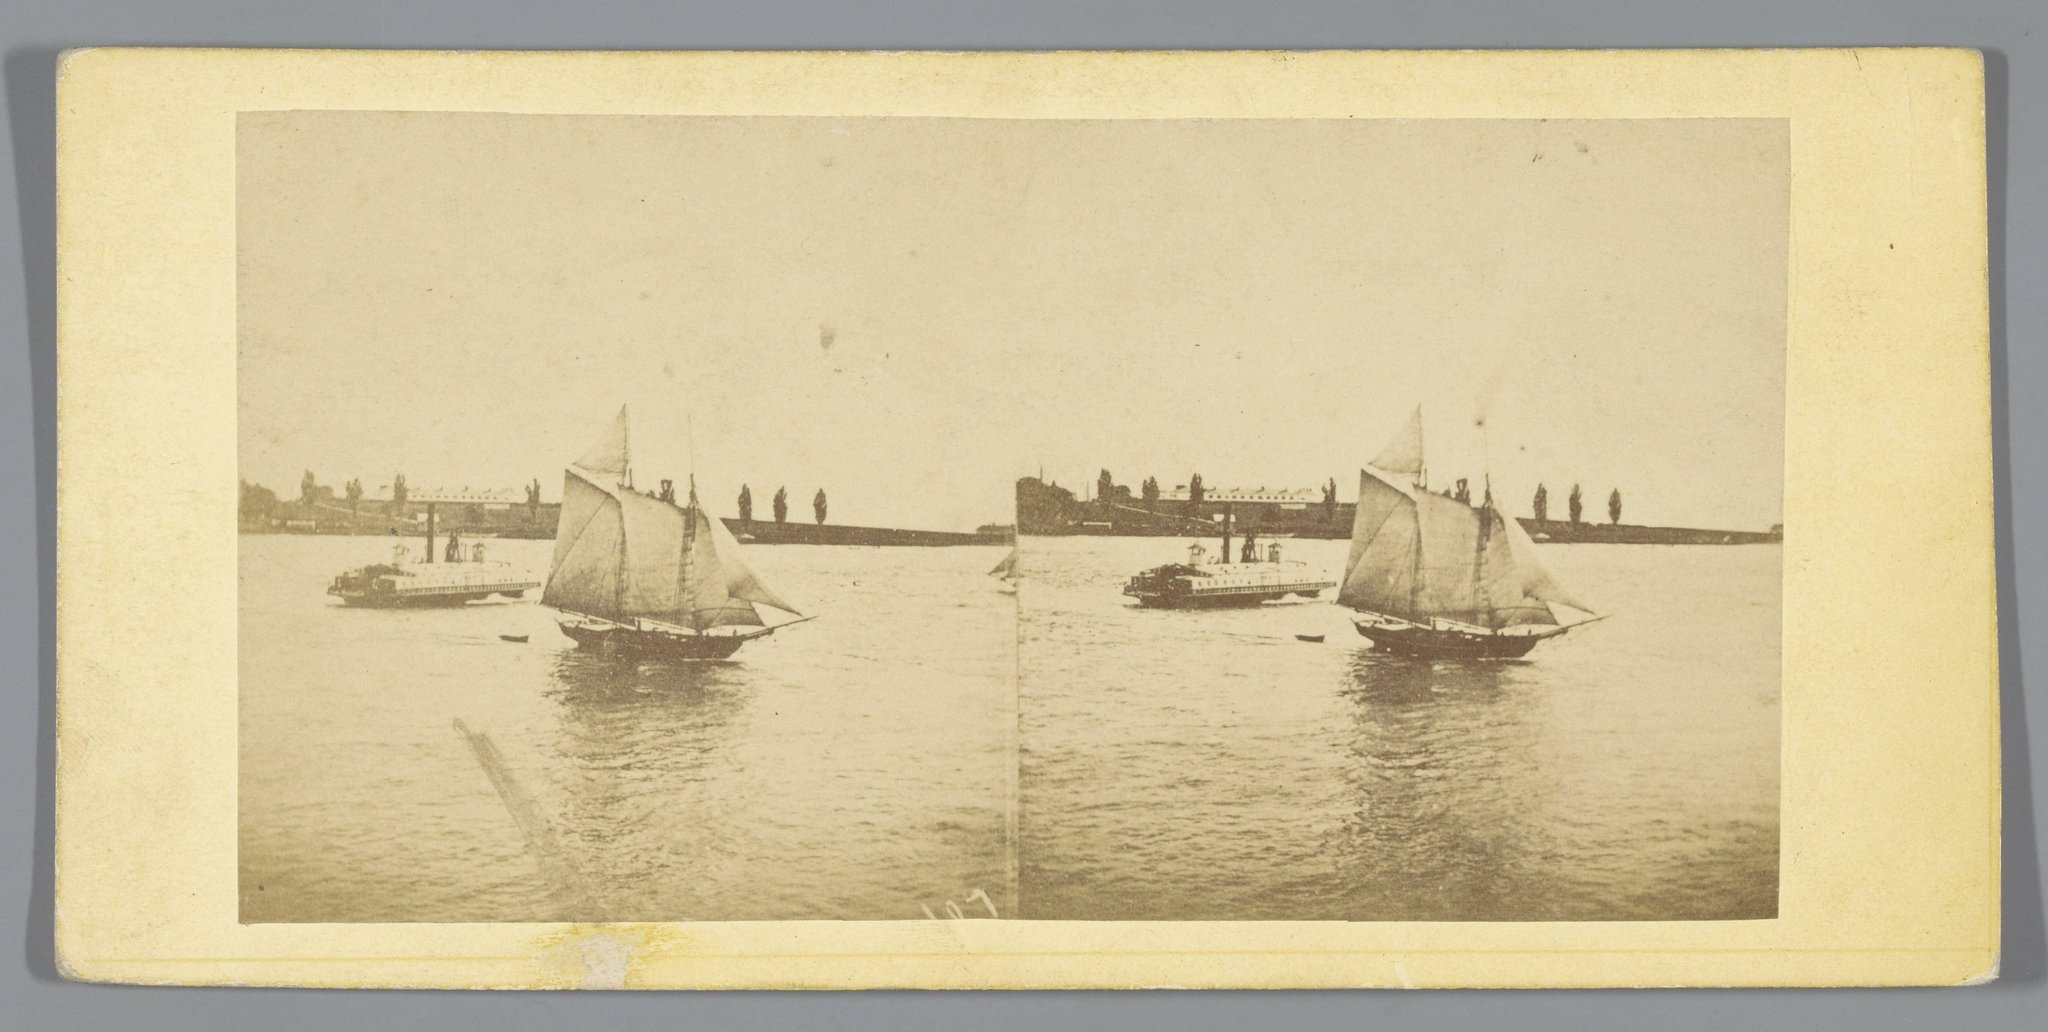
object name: stereograph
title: Zeilschip en veerboot in een kanaal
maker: Anonymous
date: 1861-1870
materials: cardboard, paper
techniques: albumen print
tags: ships (in general) - cc - more than one ship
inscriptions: stamp: ‘NOLET & [...]/ UTRECHT [...]’, inscription: ‘C.’, number: ‘No 54’, number: ‘No 40’